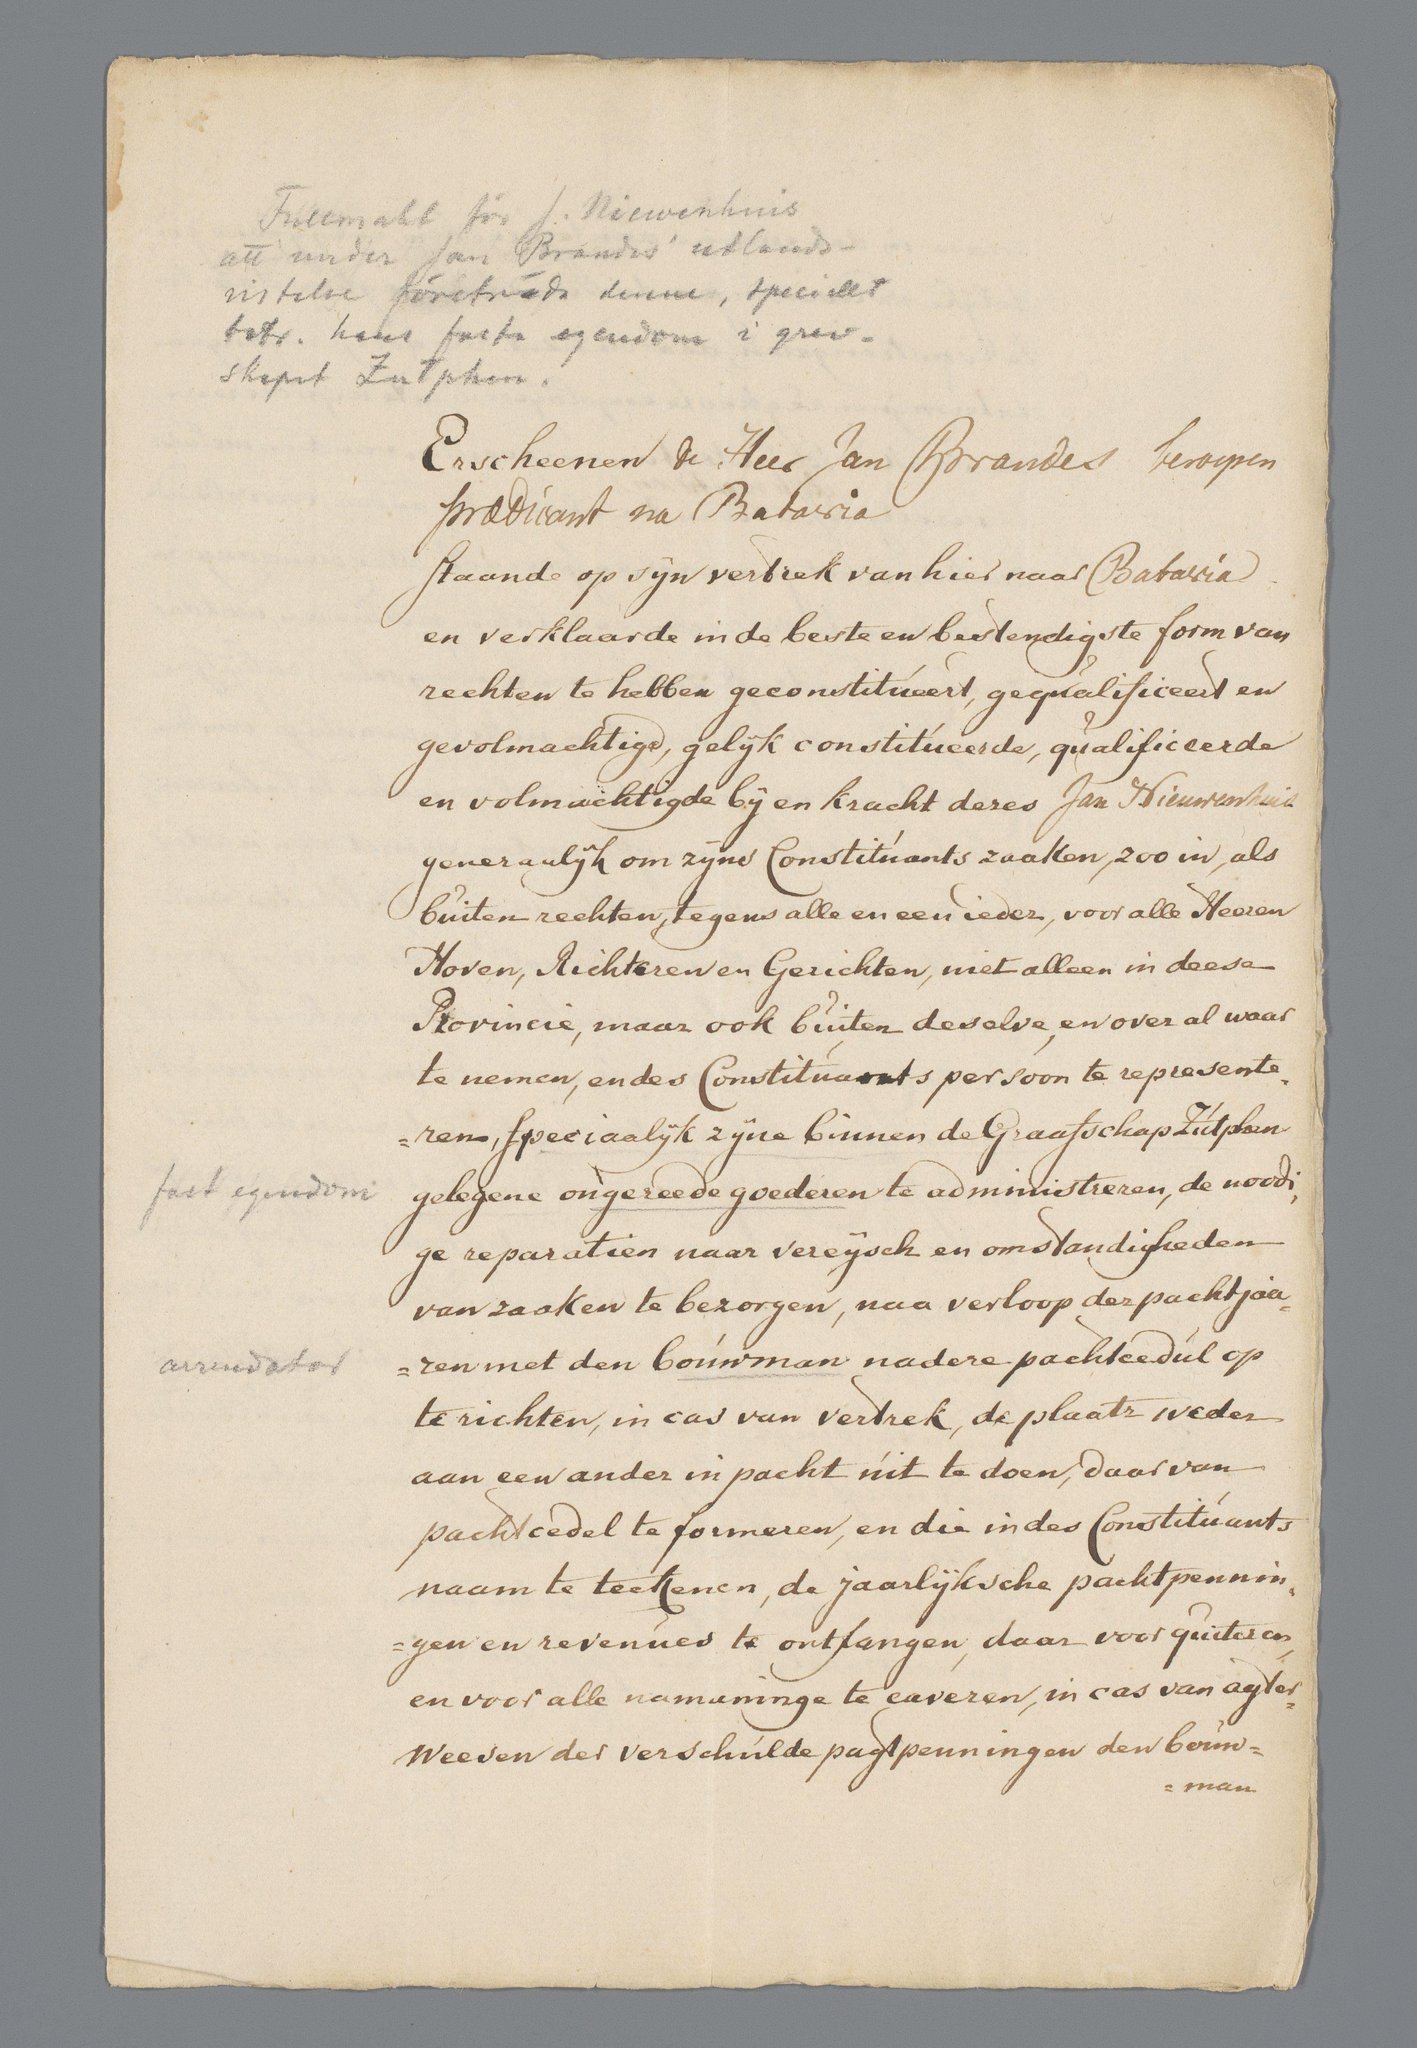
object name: document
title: Papieren van Jan Brandes van zijn beroeping als predikant bij de lutherse kerk te Batavia e.a.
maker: jan brandes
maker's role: draughtsman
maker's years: 1743-1808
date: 1777-1785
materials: paper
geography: jakarta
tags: bodegraven, draughtsman, jan brandes, batavia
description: Beroepingsbrief, notariële stukken, verweerschriften 1777-1786.